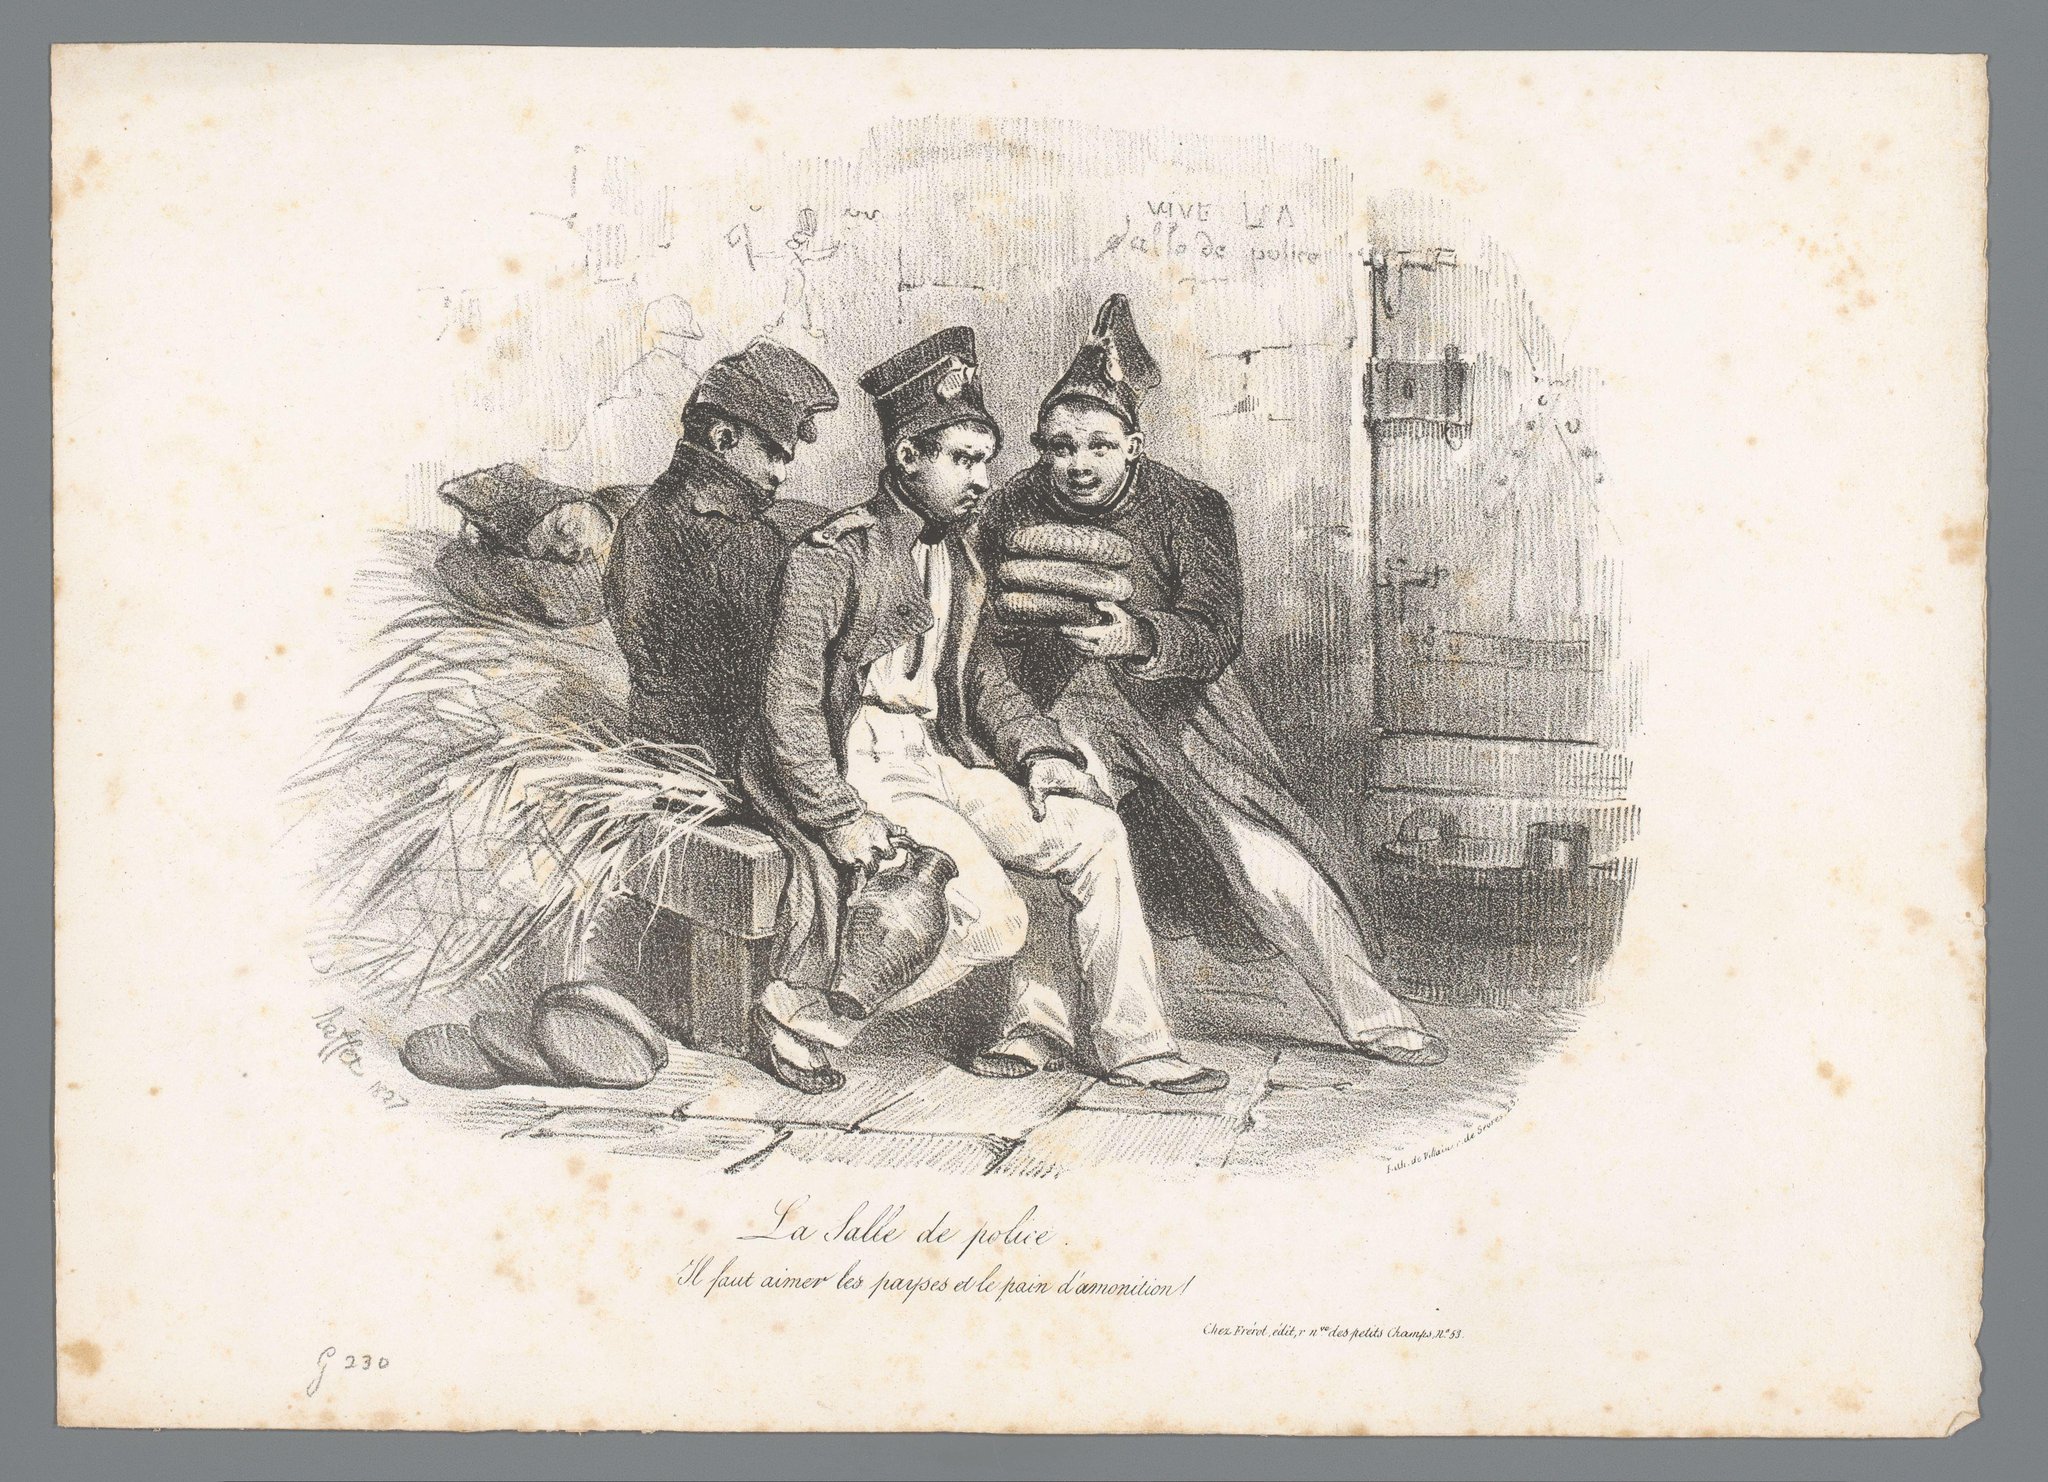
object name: print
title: Jean-Jean in de cel met andere gevangenen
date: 1827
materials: paper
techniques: lithograph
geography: paris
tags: bread, loaf, prisoner in cell or locked place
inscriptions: collector's mark: Lugt 964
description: Serie bestaat uit titelprent en zestien prenten. Elfde prent in de serie van zeventien prenten.